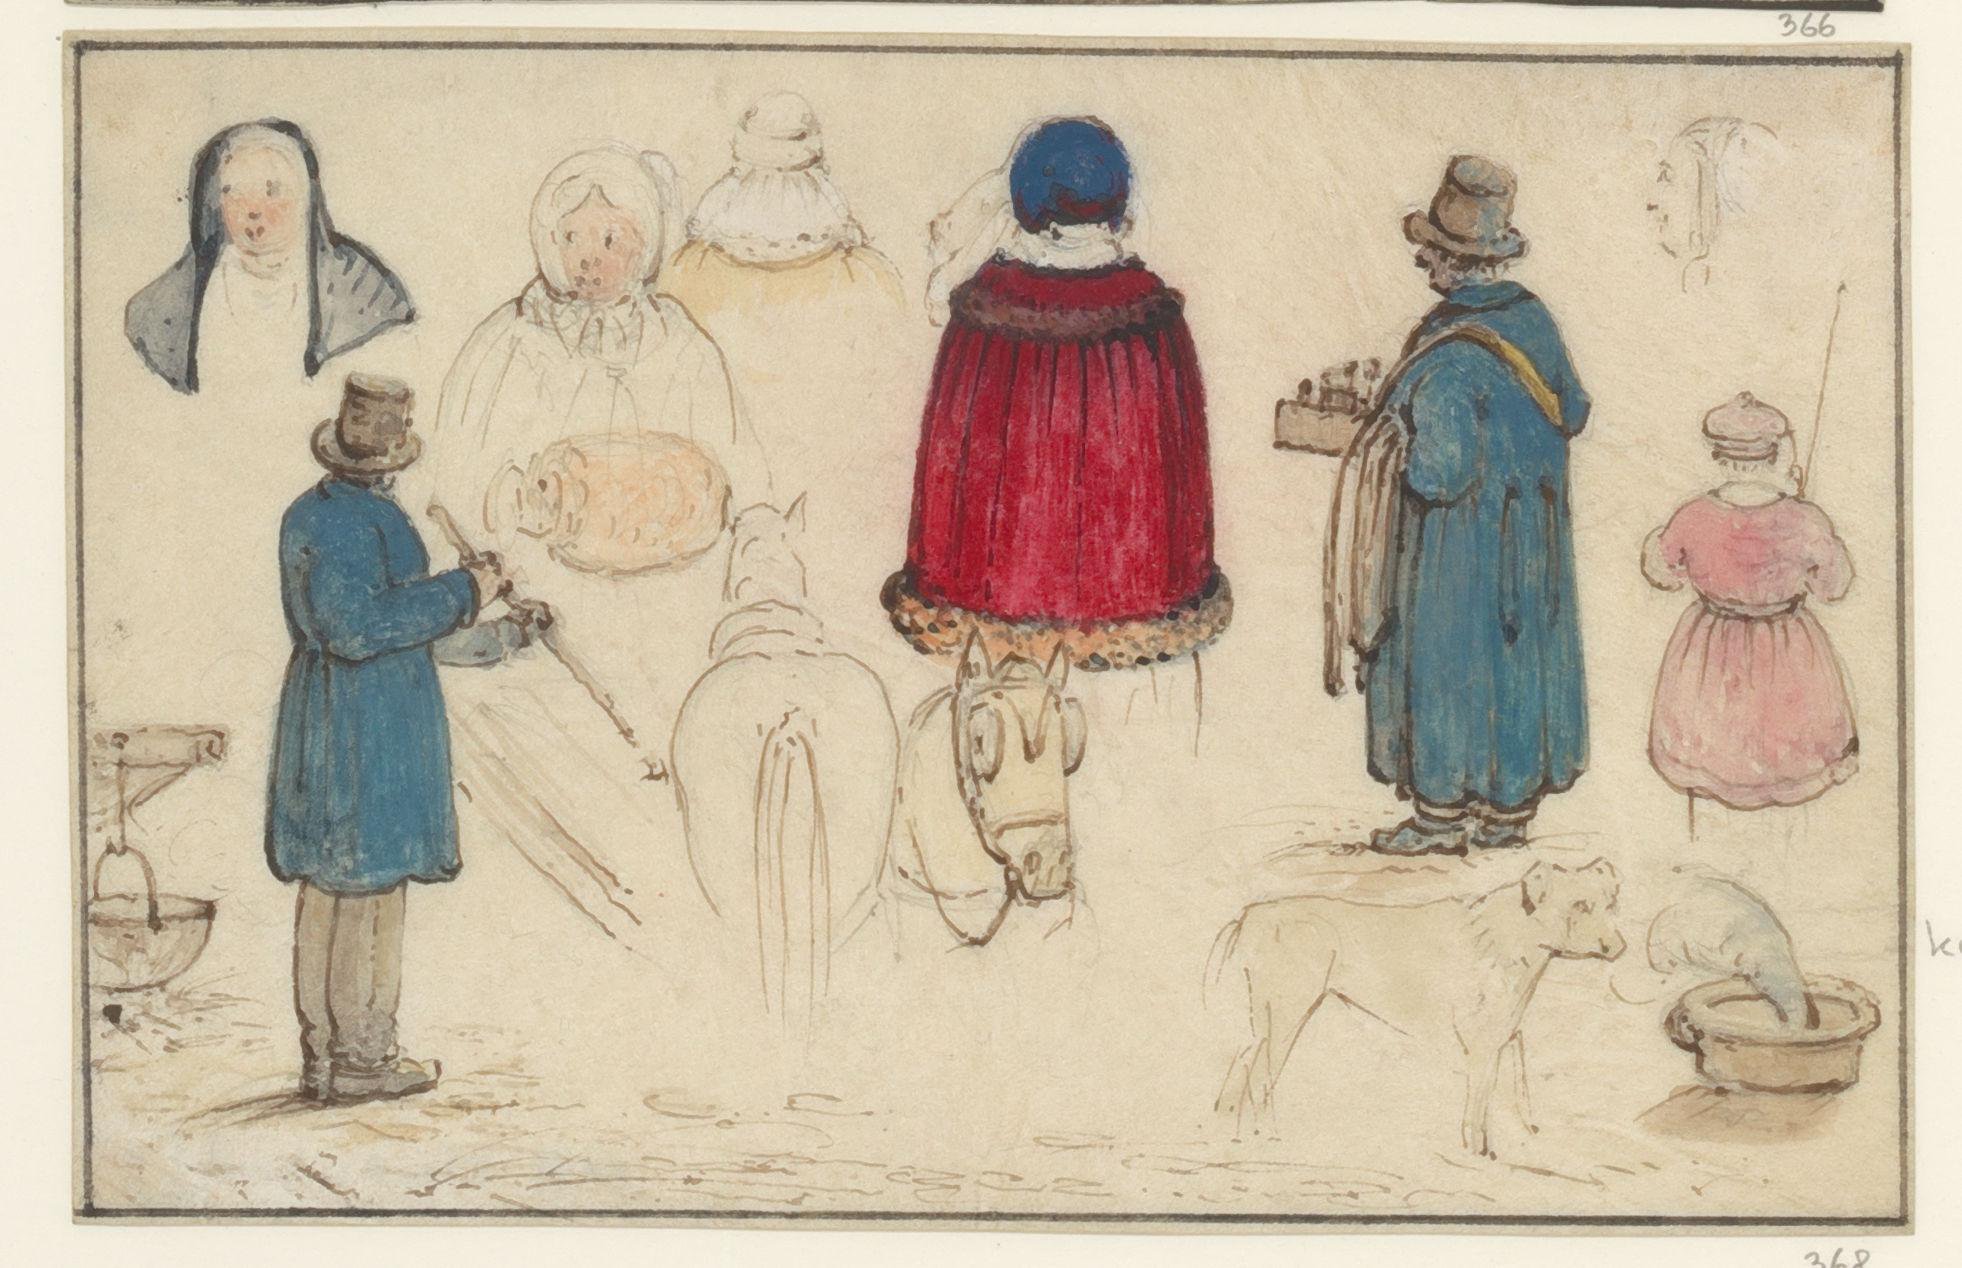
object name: drawing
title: Schetsblad met verschillende stadstypes met een paard en hond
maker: christiaan andriessen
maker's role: draughtsman, print maker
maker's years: 1775-1846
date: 1785-1846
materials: ink, paper, watercolor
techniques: brush, pen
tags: adult woman, cape, horse, dog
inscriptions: collector's mark: Lugt 1641, stamp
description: Onderwerpsrubrieken binnen de Atlas Zeden en Gewoonten: Zeden en Gewoonten in Engeren Zin, De Kleeding, Kleederdrachten (tijdvakken), Het begin der 19de eeuw. Teekeningen van Christiaan Andriessen, † 1819. mannen en vrouwen. stadstypen.